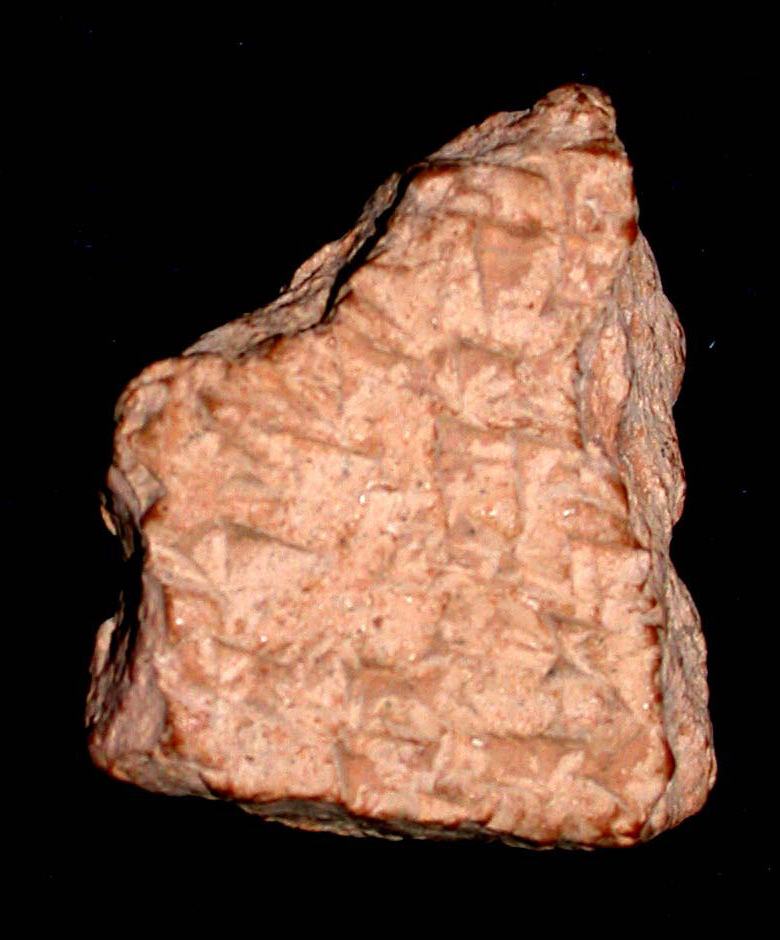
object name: cuneiform tablet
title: Cuneiform tablet: bilingual unidentified fragment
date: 333-1 BCE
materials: clay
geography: mesopotamia